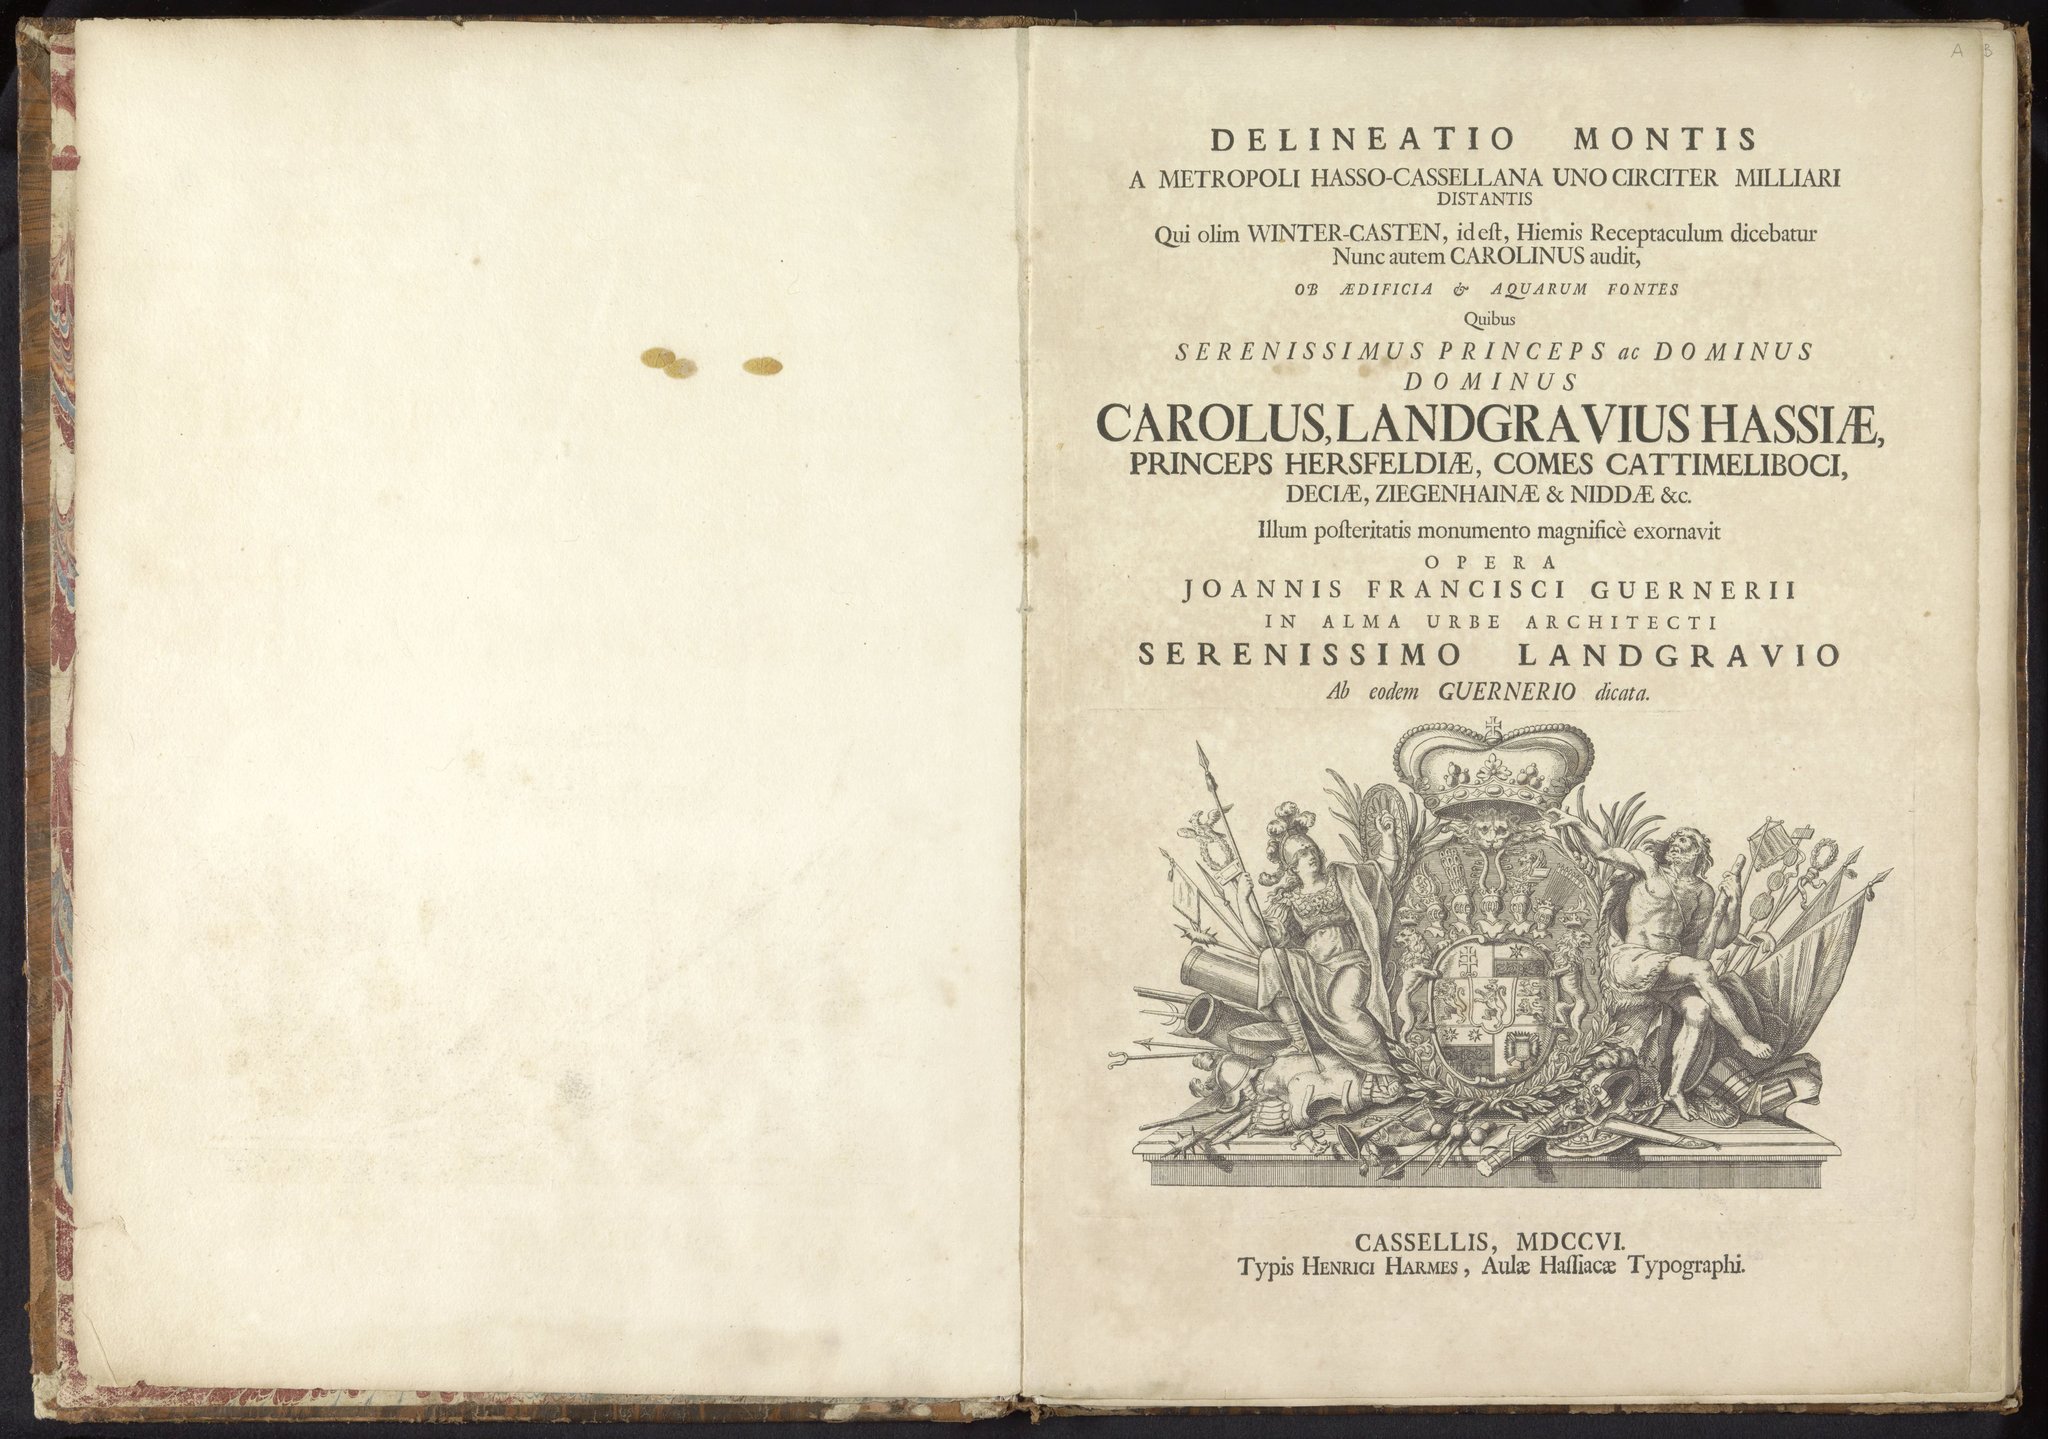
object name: print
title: Titelprent met het wapen van Karel van Hessen-Kassel geflankeerd door Minerva en Hercules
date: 1706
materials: paper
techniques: etching, letterpress printing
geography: italy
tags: coat of arms (symbol of sovereignty), (story of) hercules (heracles), (story of) minerva (pallas, athena)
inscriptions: date